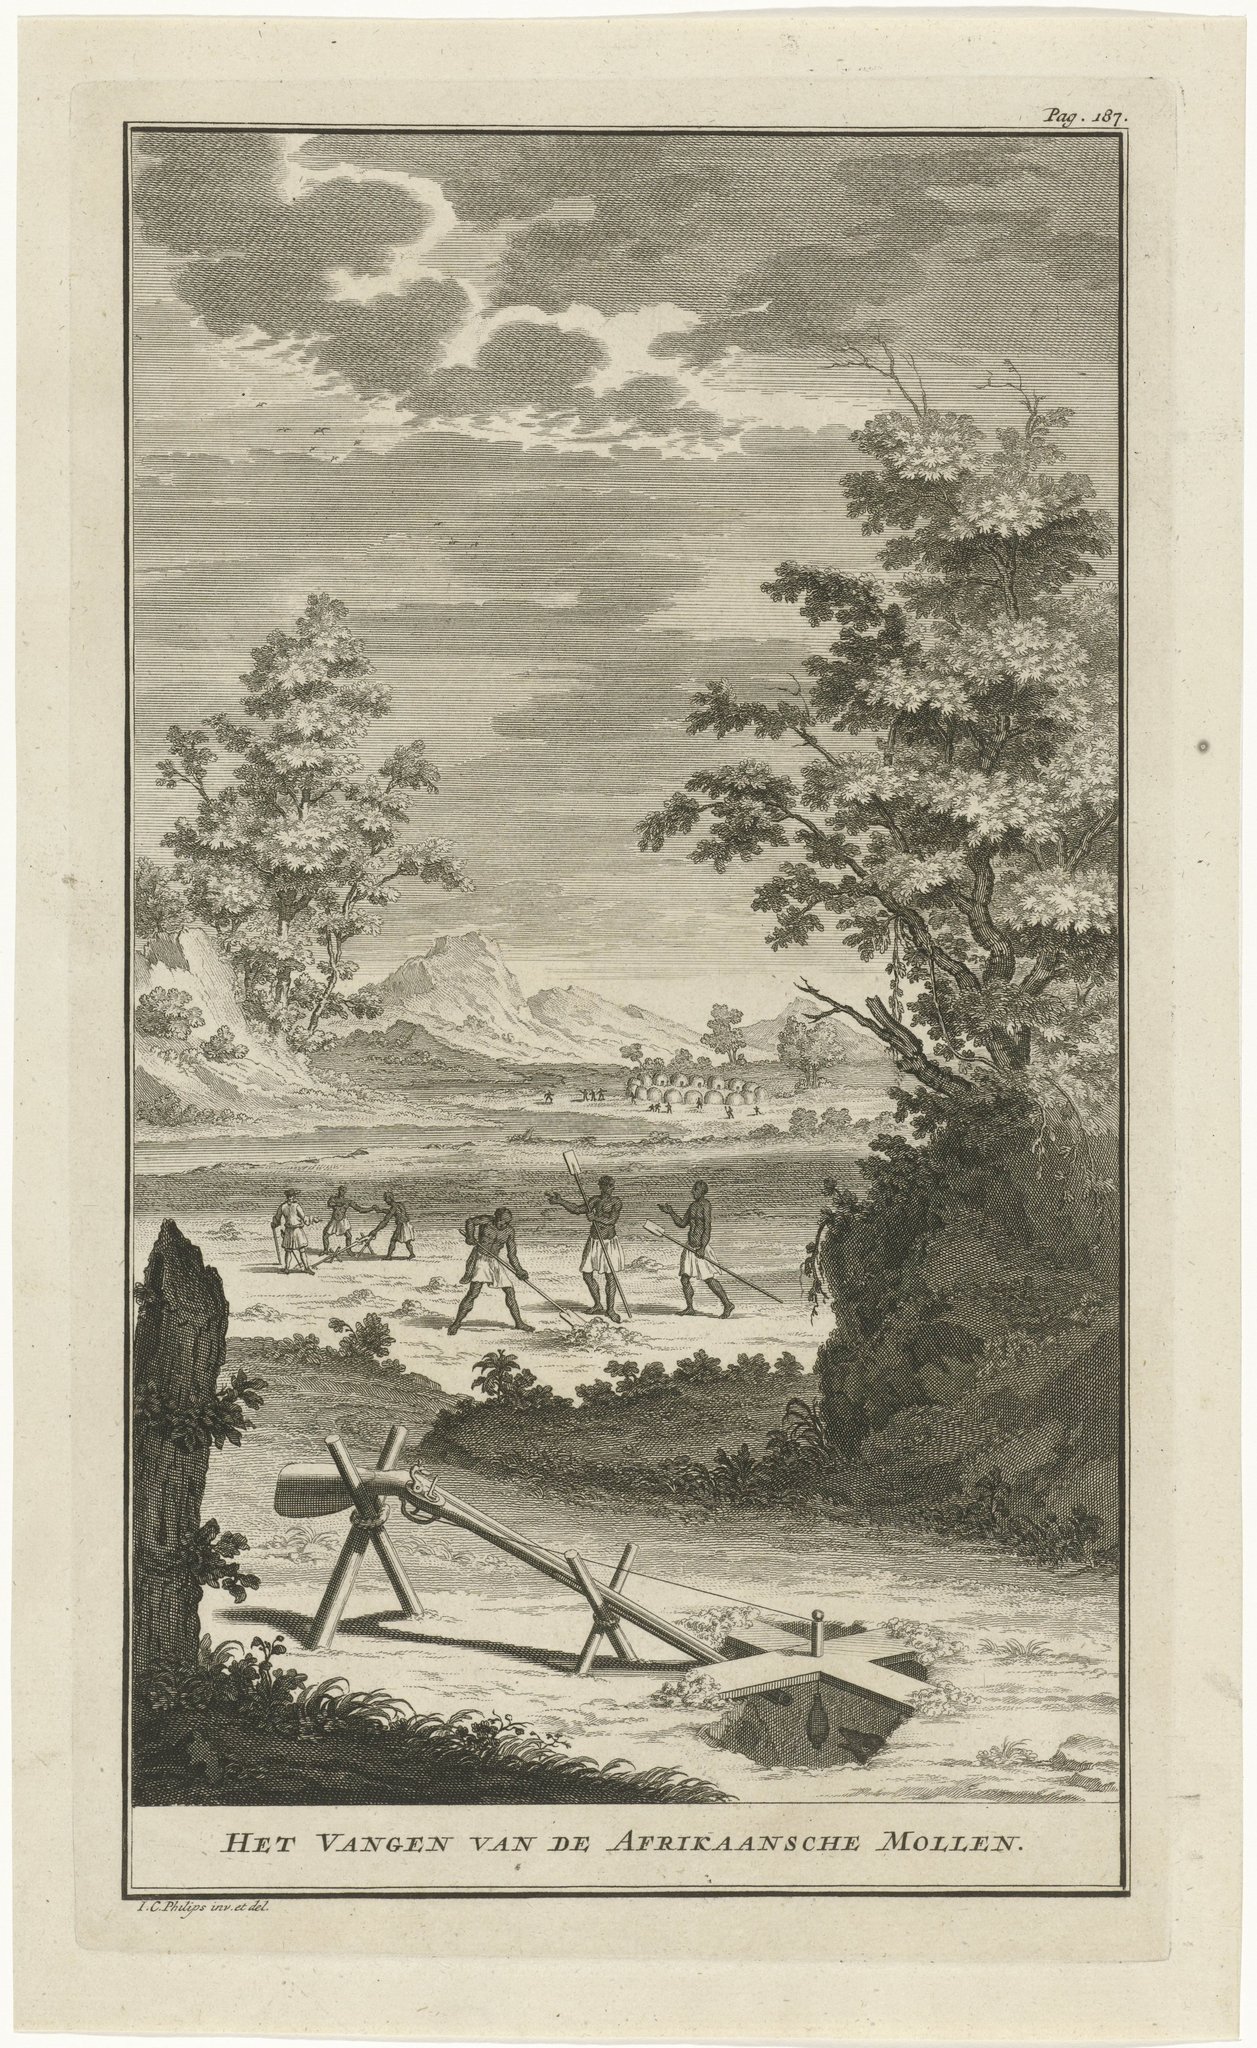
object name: book illustration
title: Het Vangen van de Afrikaansche Mollen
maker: jan caspar philips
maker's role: draughtsman, print maker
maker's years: 1700-1775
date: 1727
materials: paper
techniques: engraving, etching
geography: amsterdam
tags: other mammals: mole, the kill (~ hunting), khoikhoi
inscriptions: collector's mark: Lugt 2228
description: Prent als illustratie gebruikt in: Kolbe, Peter. Naaukeurige en uitvoerige beschryving van de kaap de Goede Hoop; behelzende een zeer omstandig verhaal van den tegenwoordigen toestant van dat vermaarde gewest ... beschryving van de oorsprong der Hottentotten, deel I, p. 187. Amsterdam: Balthazar Lakeman, 1727.